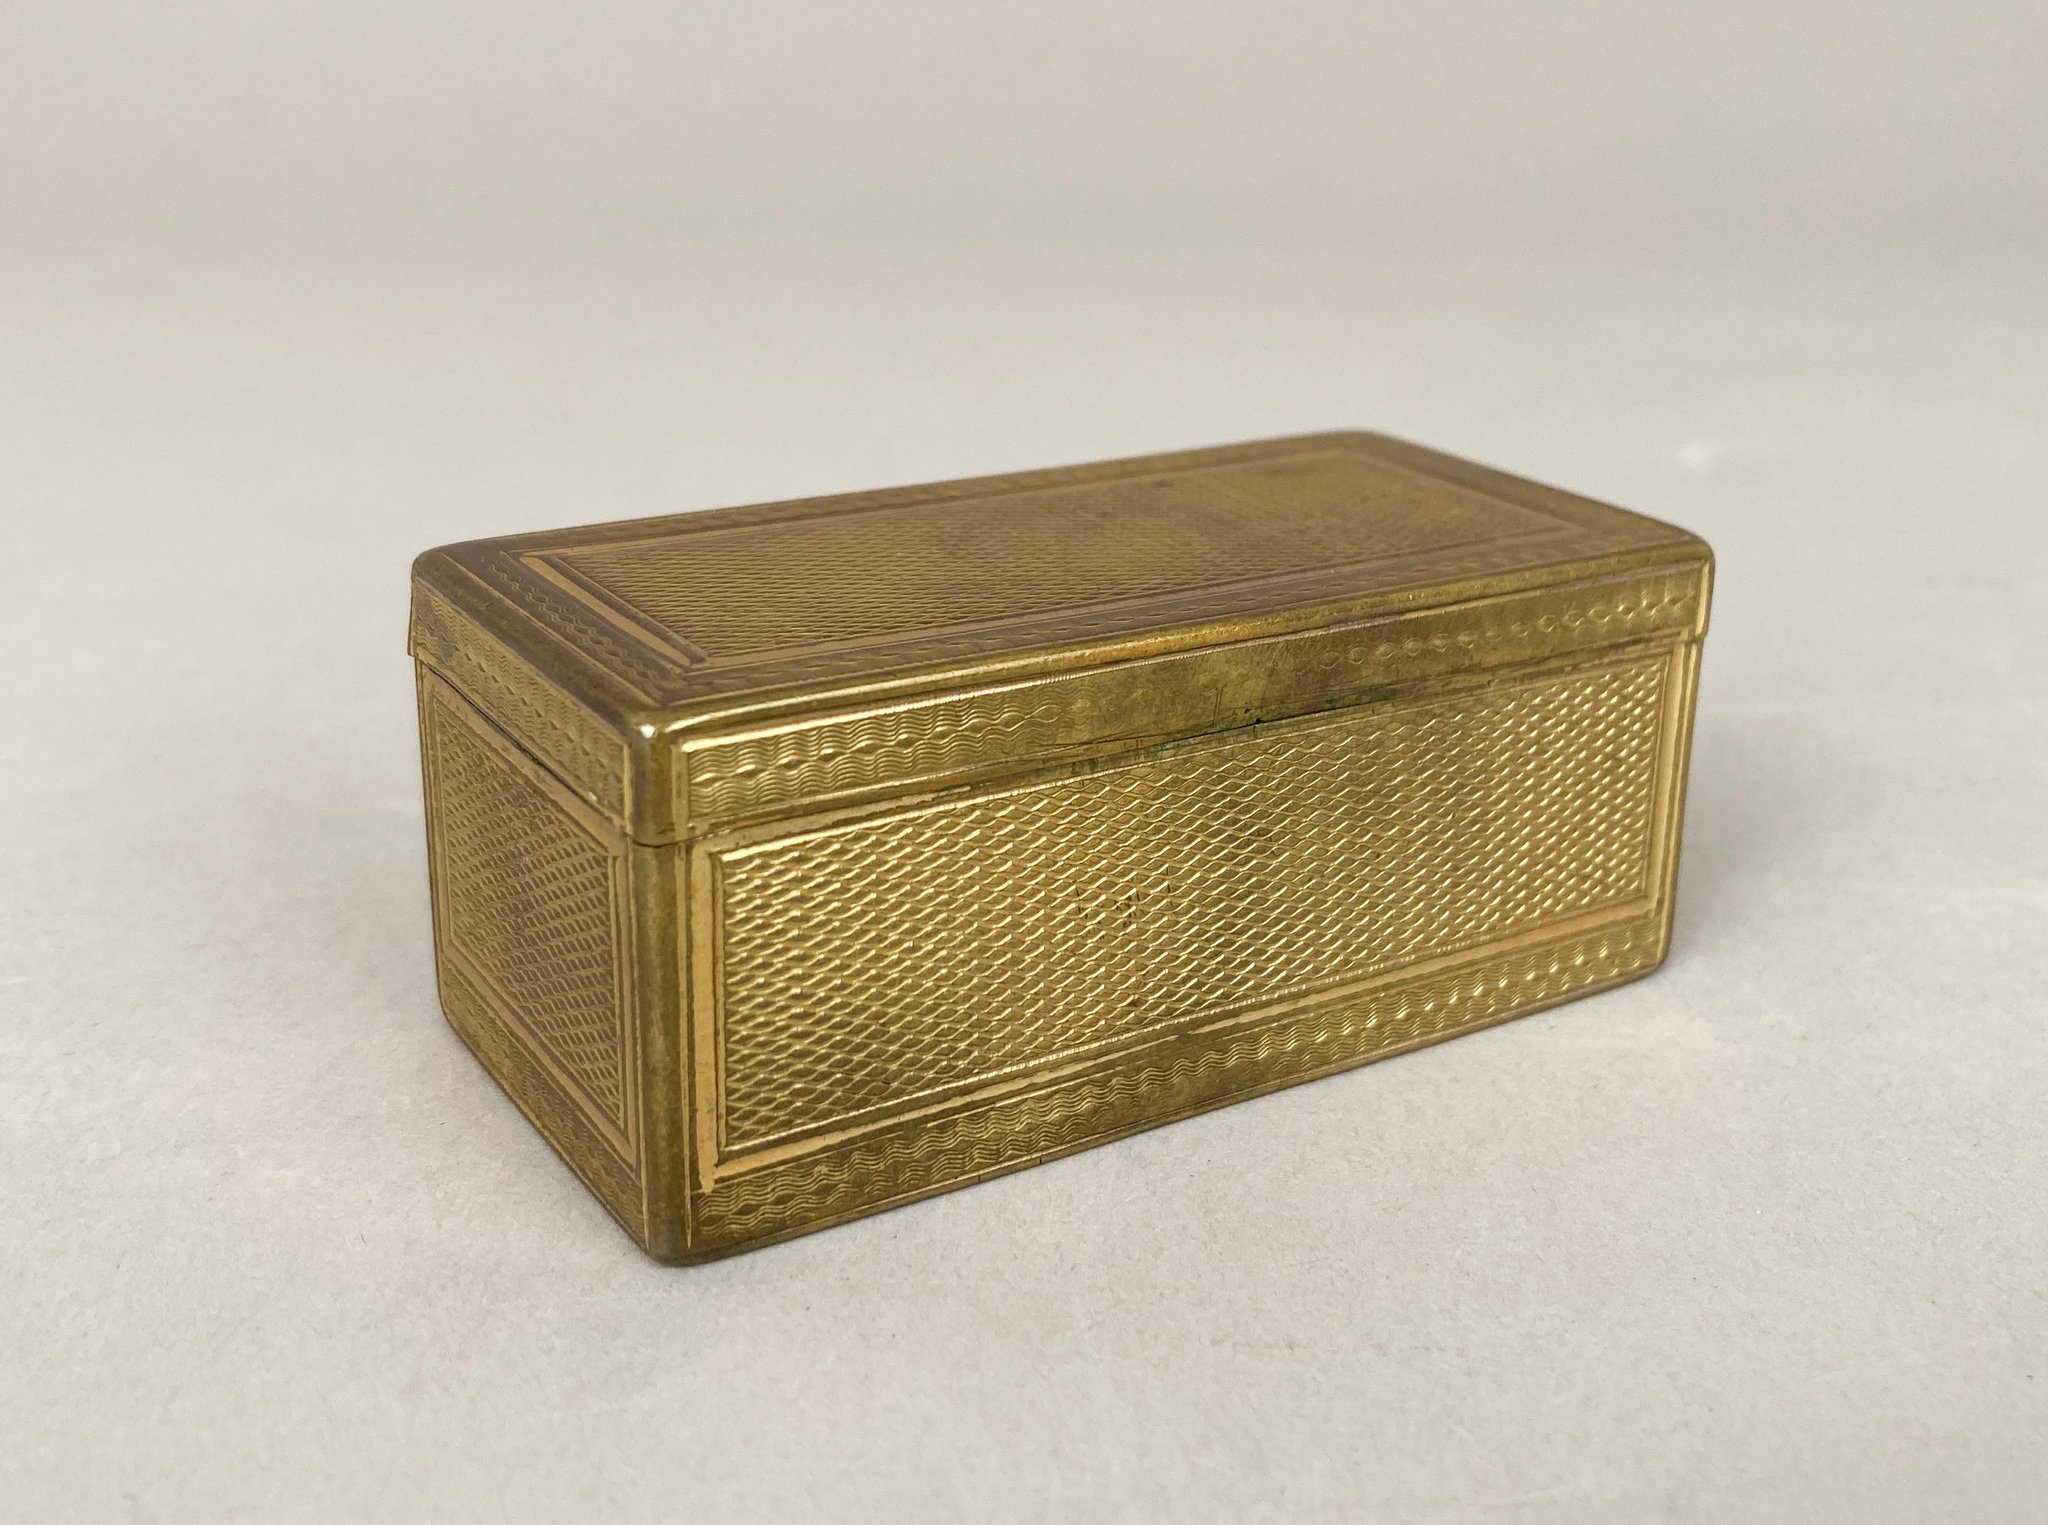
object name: box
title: Rectangular box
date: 1801-1900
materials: gilt, metal